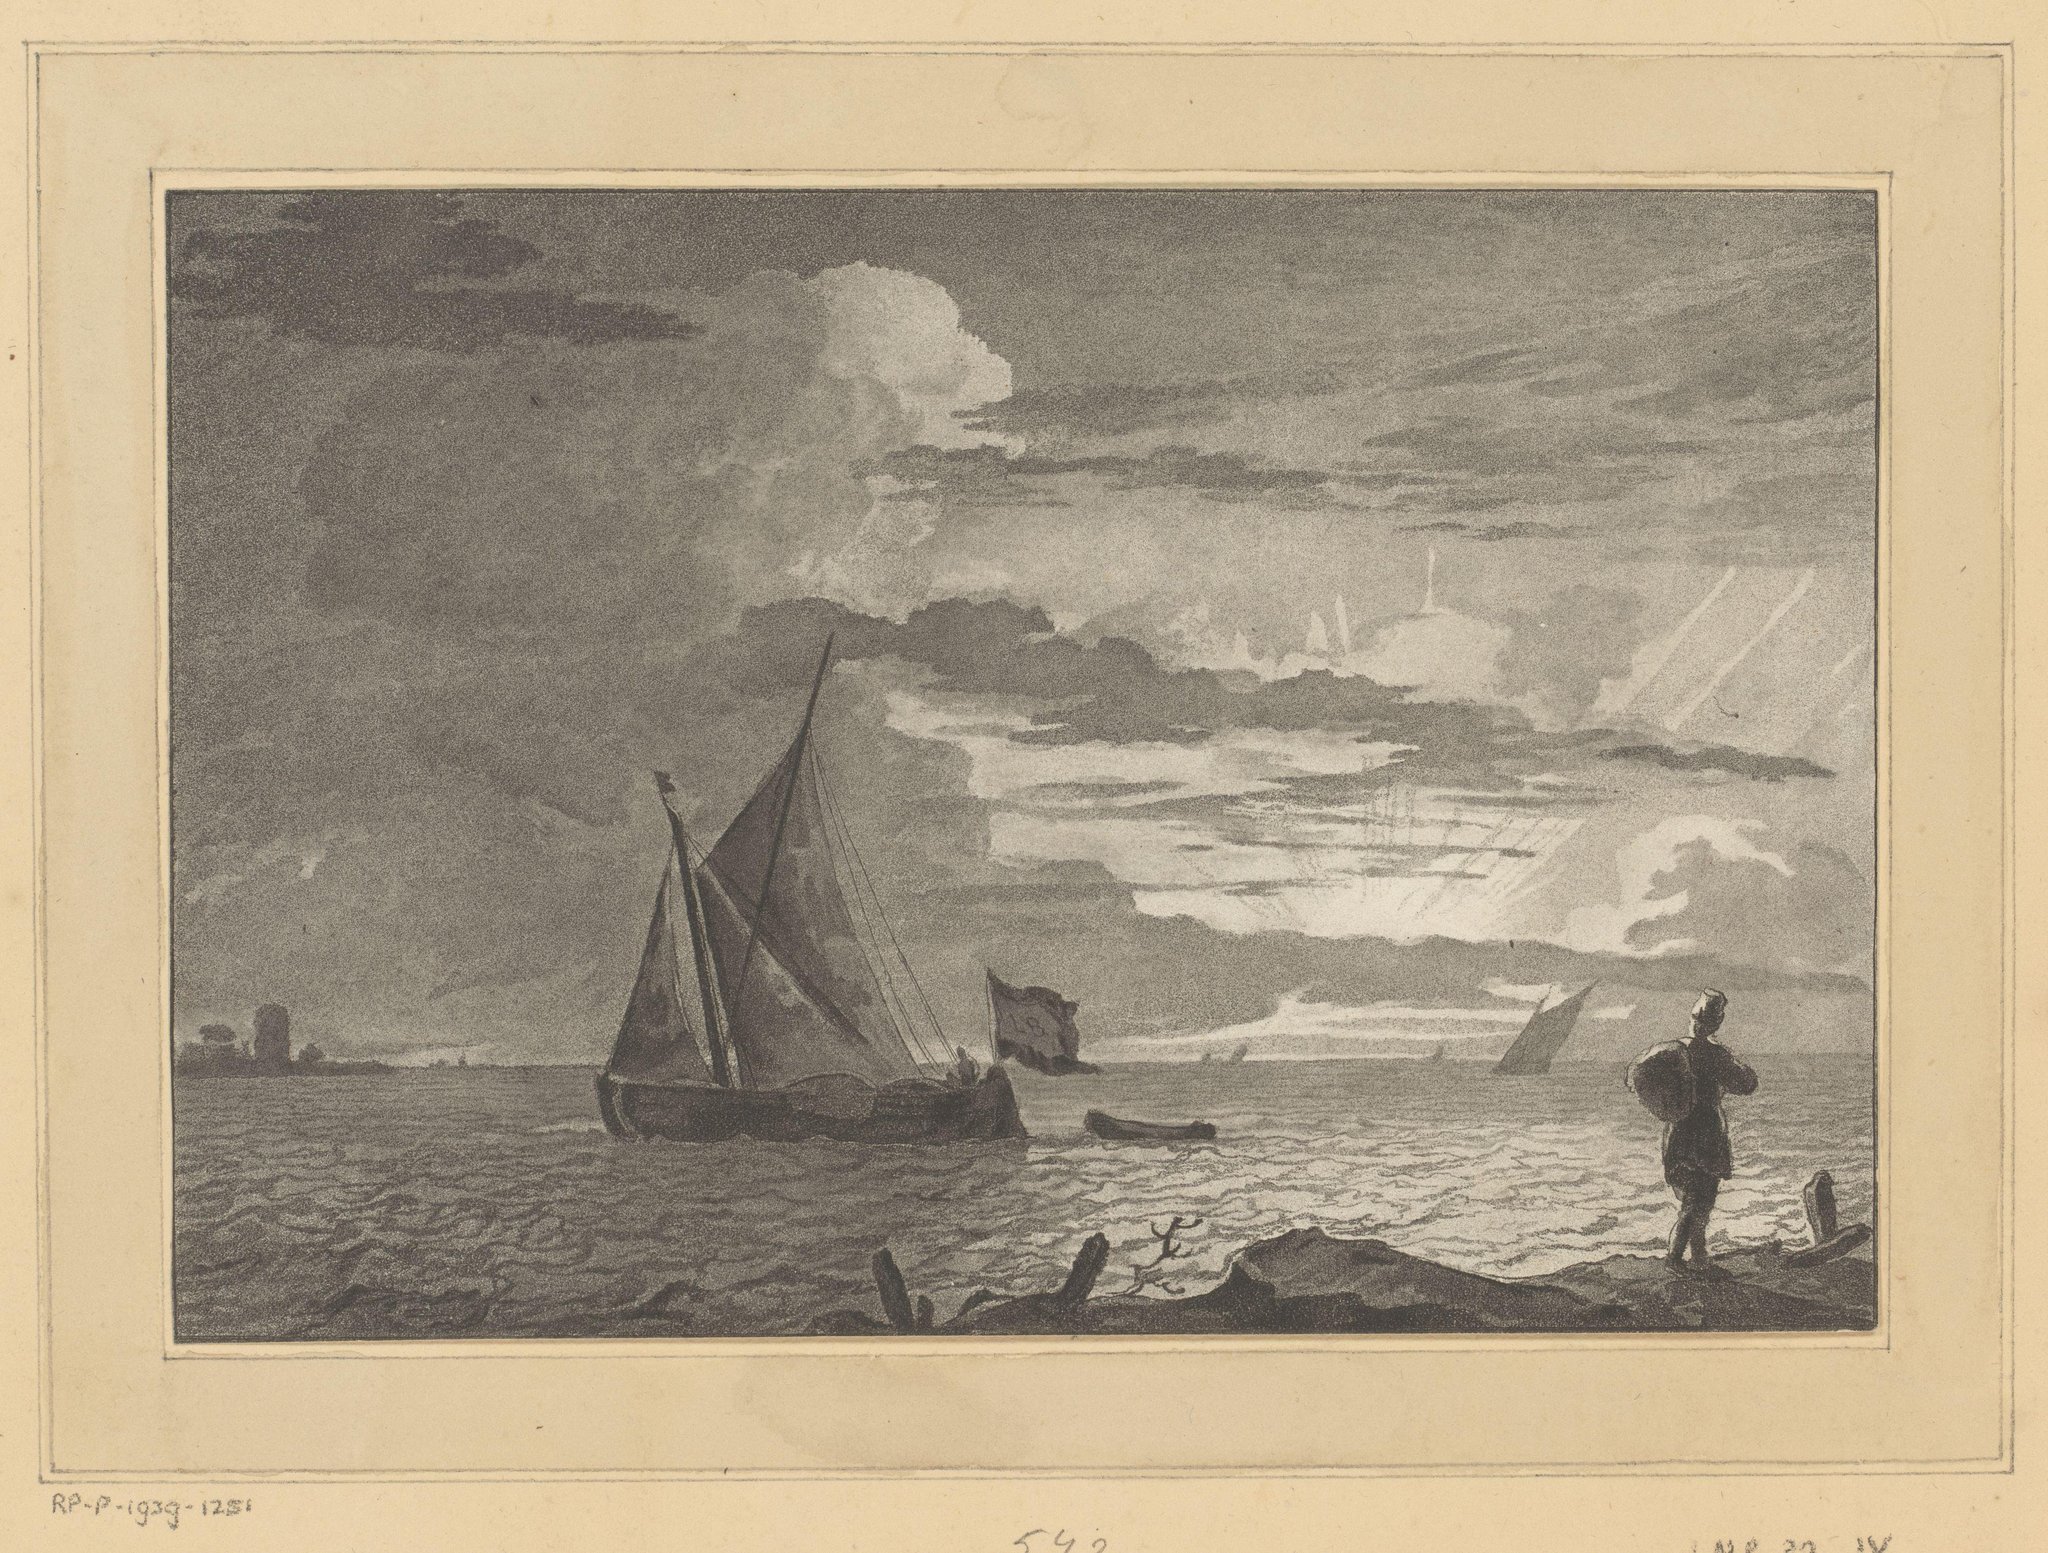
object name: print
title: Man met zak op de schouder bij zonsopgang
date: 1781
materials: paper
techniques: transfer, print drawing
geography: amsterdam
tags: sailing-ship, sailing-boat, sunrise, carrying something on the head or on the shoulders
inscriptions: inscription: ‘L. Bakhuizen del. CPloos van Amstel J.C. Fecit. 1781’, collector's mark: Lugt 2725, collector's mark: ‘RIJKS / MUSM’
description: Rechts op de voorgrond een man met een zak op de schouder kijkend naar de schepen en de zonsopgang. De prent ligt los in een album, zie blad 32.